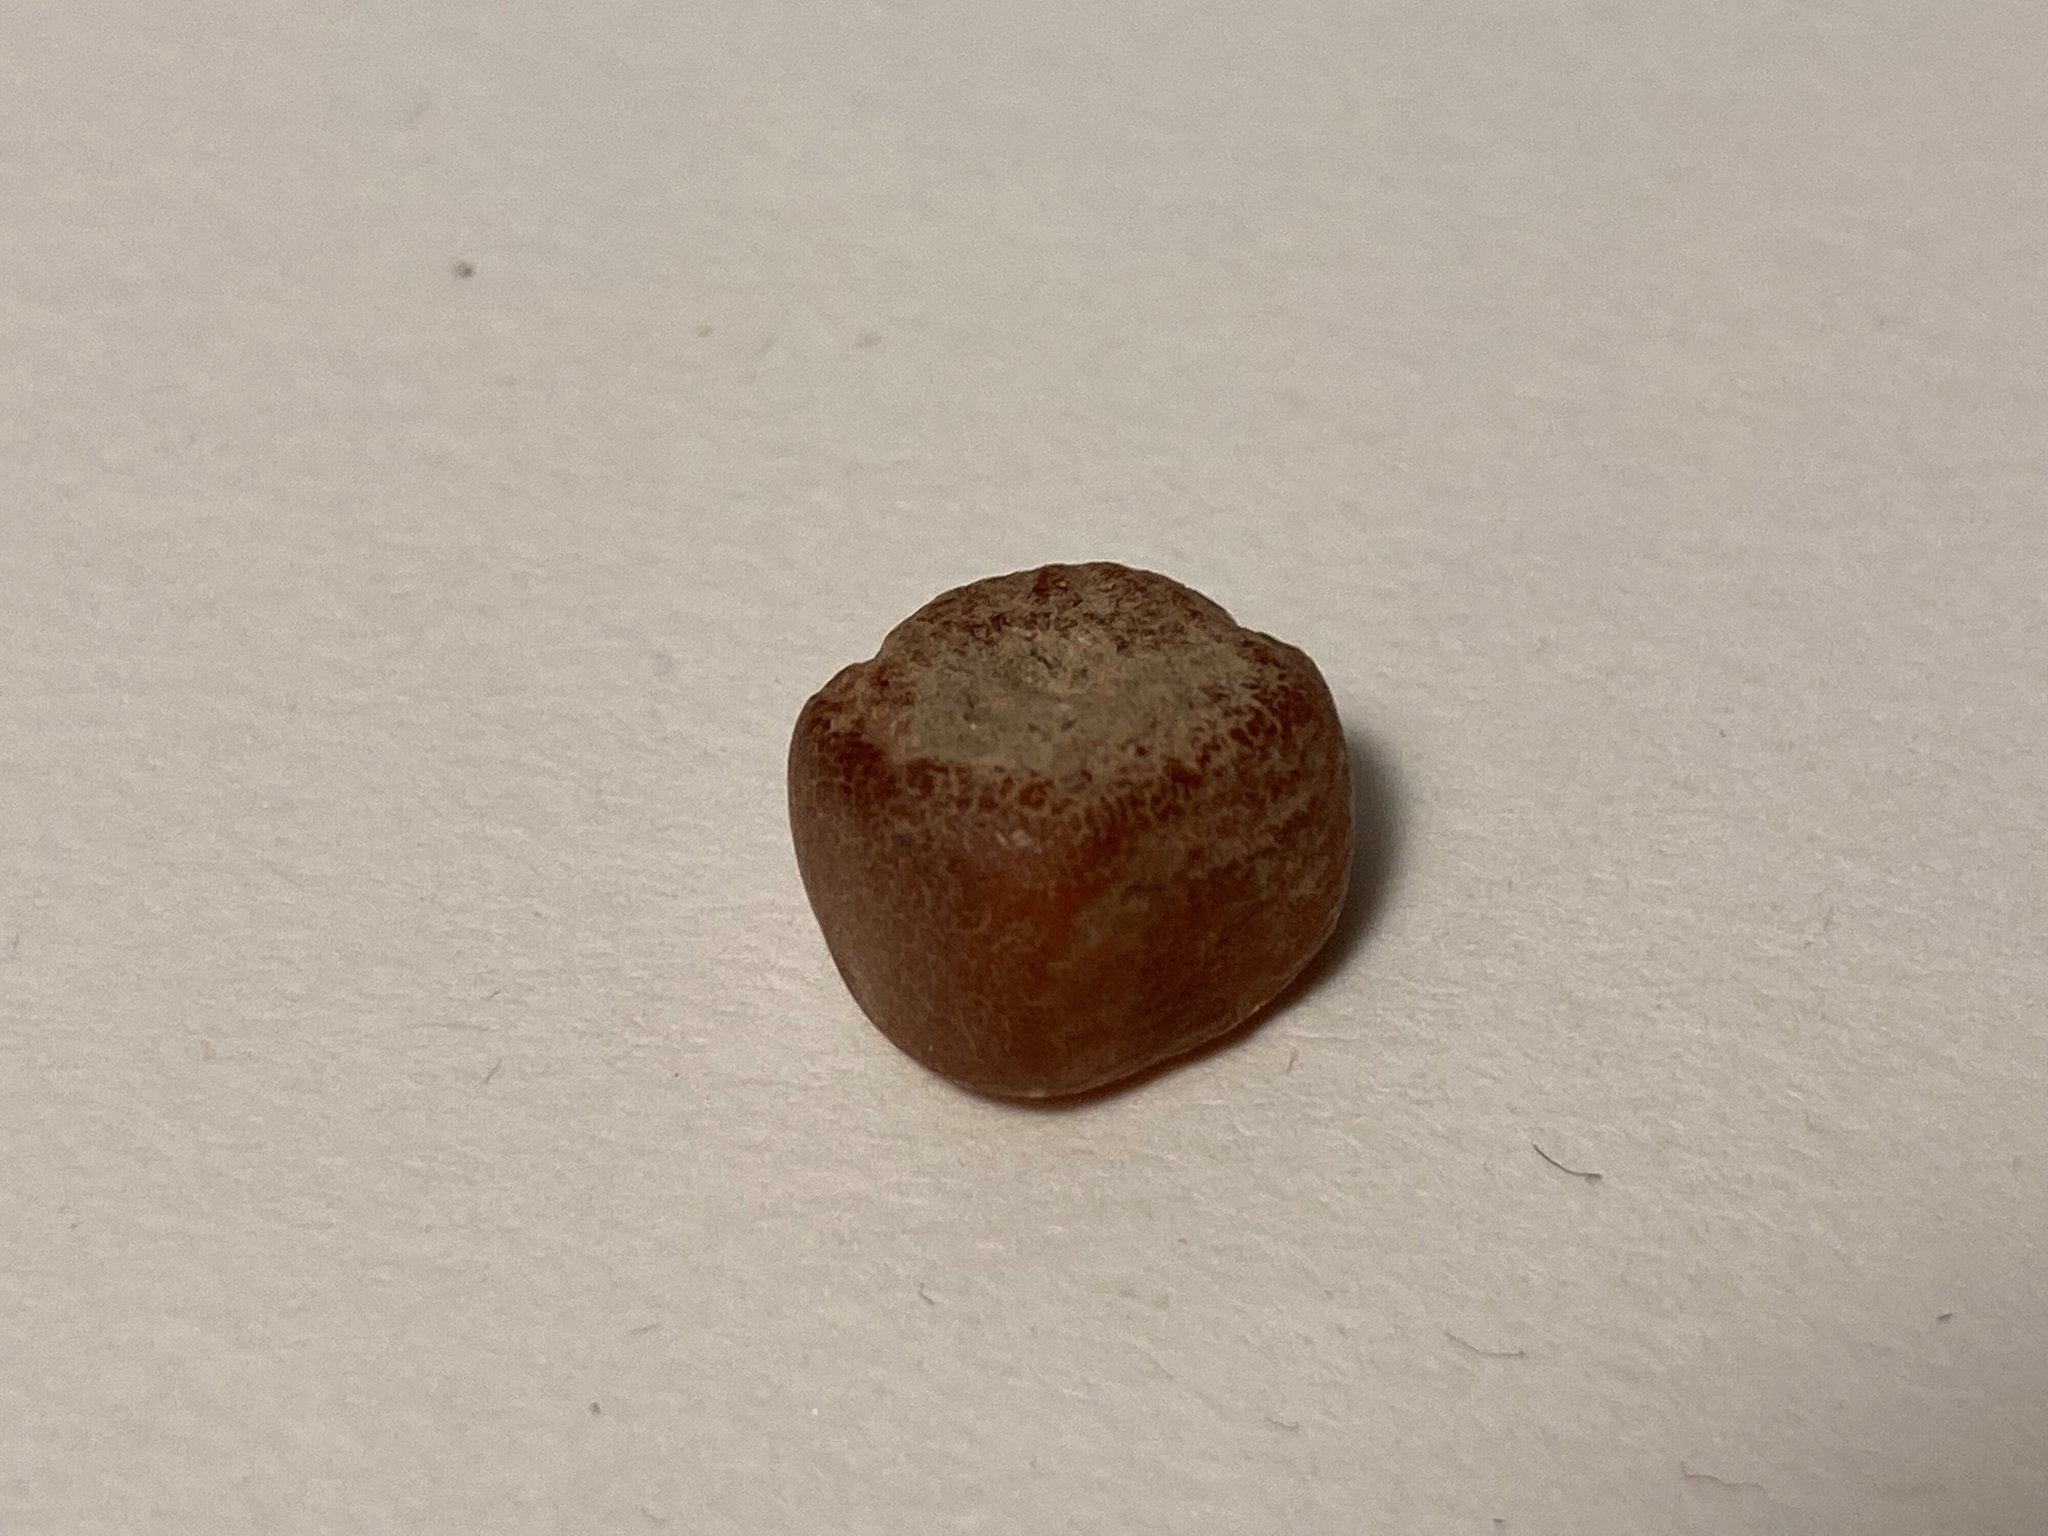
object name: bead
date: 701-1200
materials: stone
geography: iran